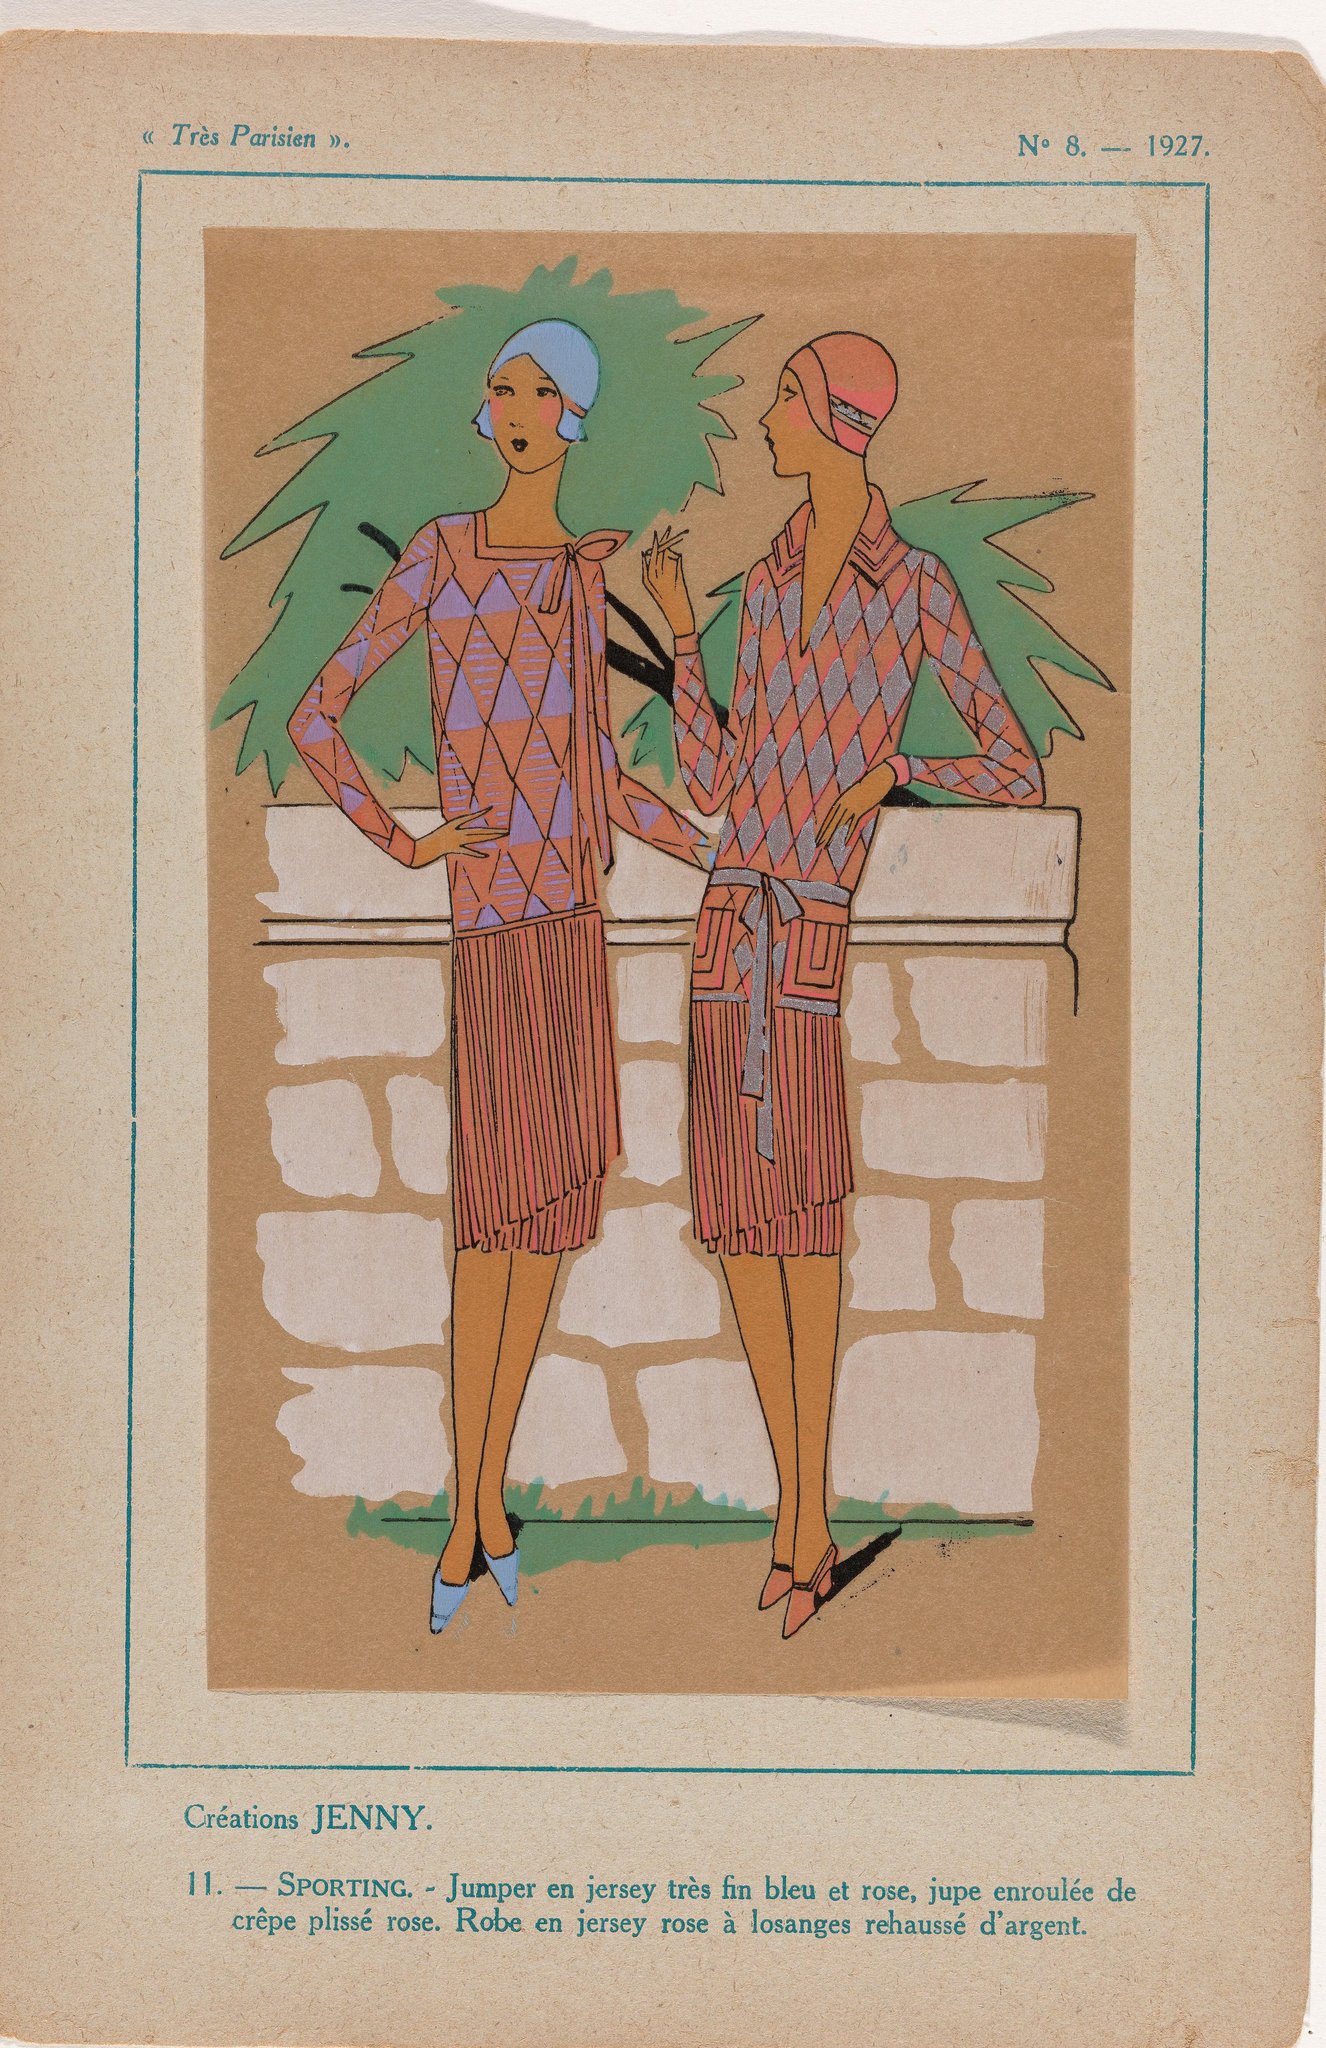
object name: fashion print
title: Très Parisien 1927, No. 8 : -11: Créations Jenny (...)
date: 1927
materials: paper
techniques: brush, hand coloring, letterpress printing, lithography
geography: paris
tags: clothing for the upper part of the body (sweater) (+ women's clothes), fashion plates, skirt (+ women's clothes), dress, gown (+ women's clothes)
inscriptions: caption: ‘Créations JENNY. / 11. - SPORTING. - Jumper en jersey très fin bleu et rose, jupe enroulée de crêpe plissé rose. Robe en jersey rose à losanges rehaussé d'argent.’, title: ‘"Très Parisien" / No 8. - 1927.’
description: Ontwerpen van Jenny. 'Jumper' (pull-over) van jersey in blauw en roze. Wikkelrok van geplisseerde roze crêpe. Jurk van roze jersey versierd met zilverkleurige ruiten. Accessoires: cloche (pothoed), pumps. Prent uit het modetijdschrift Très Parisien (1920-1936).